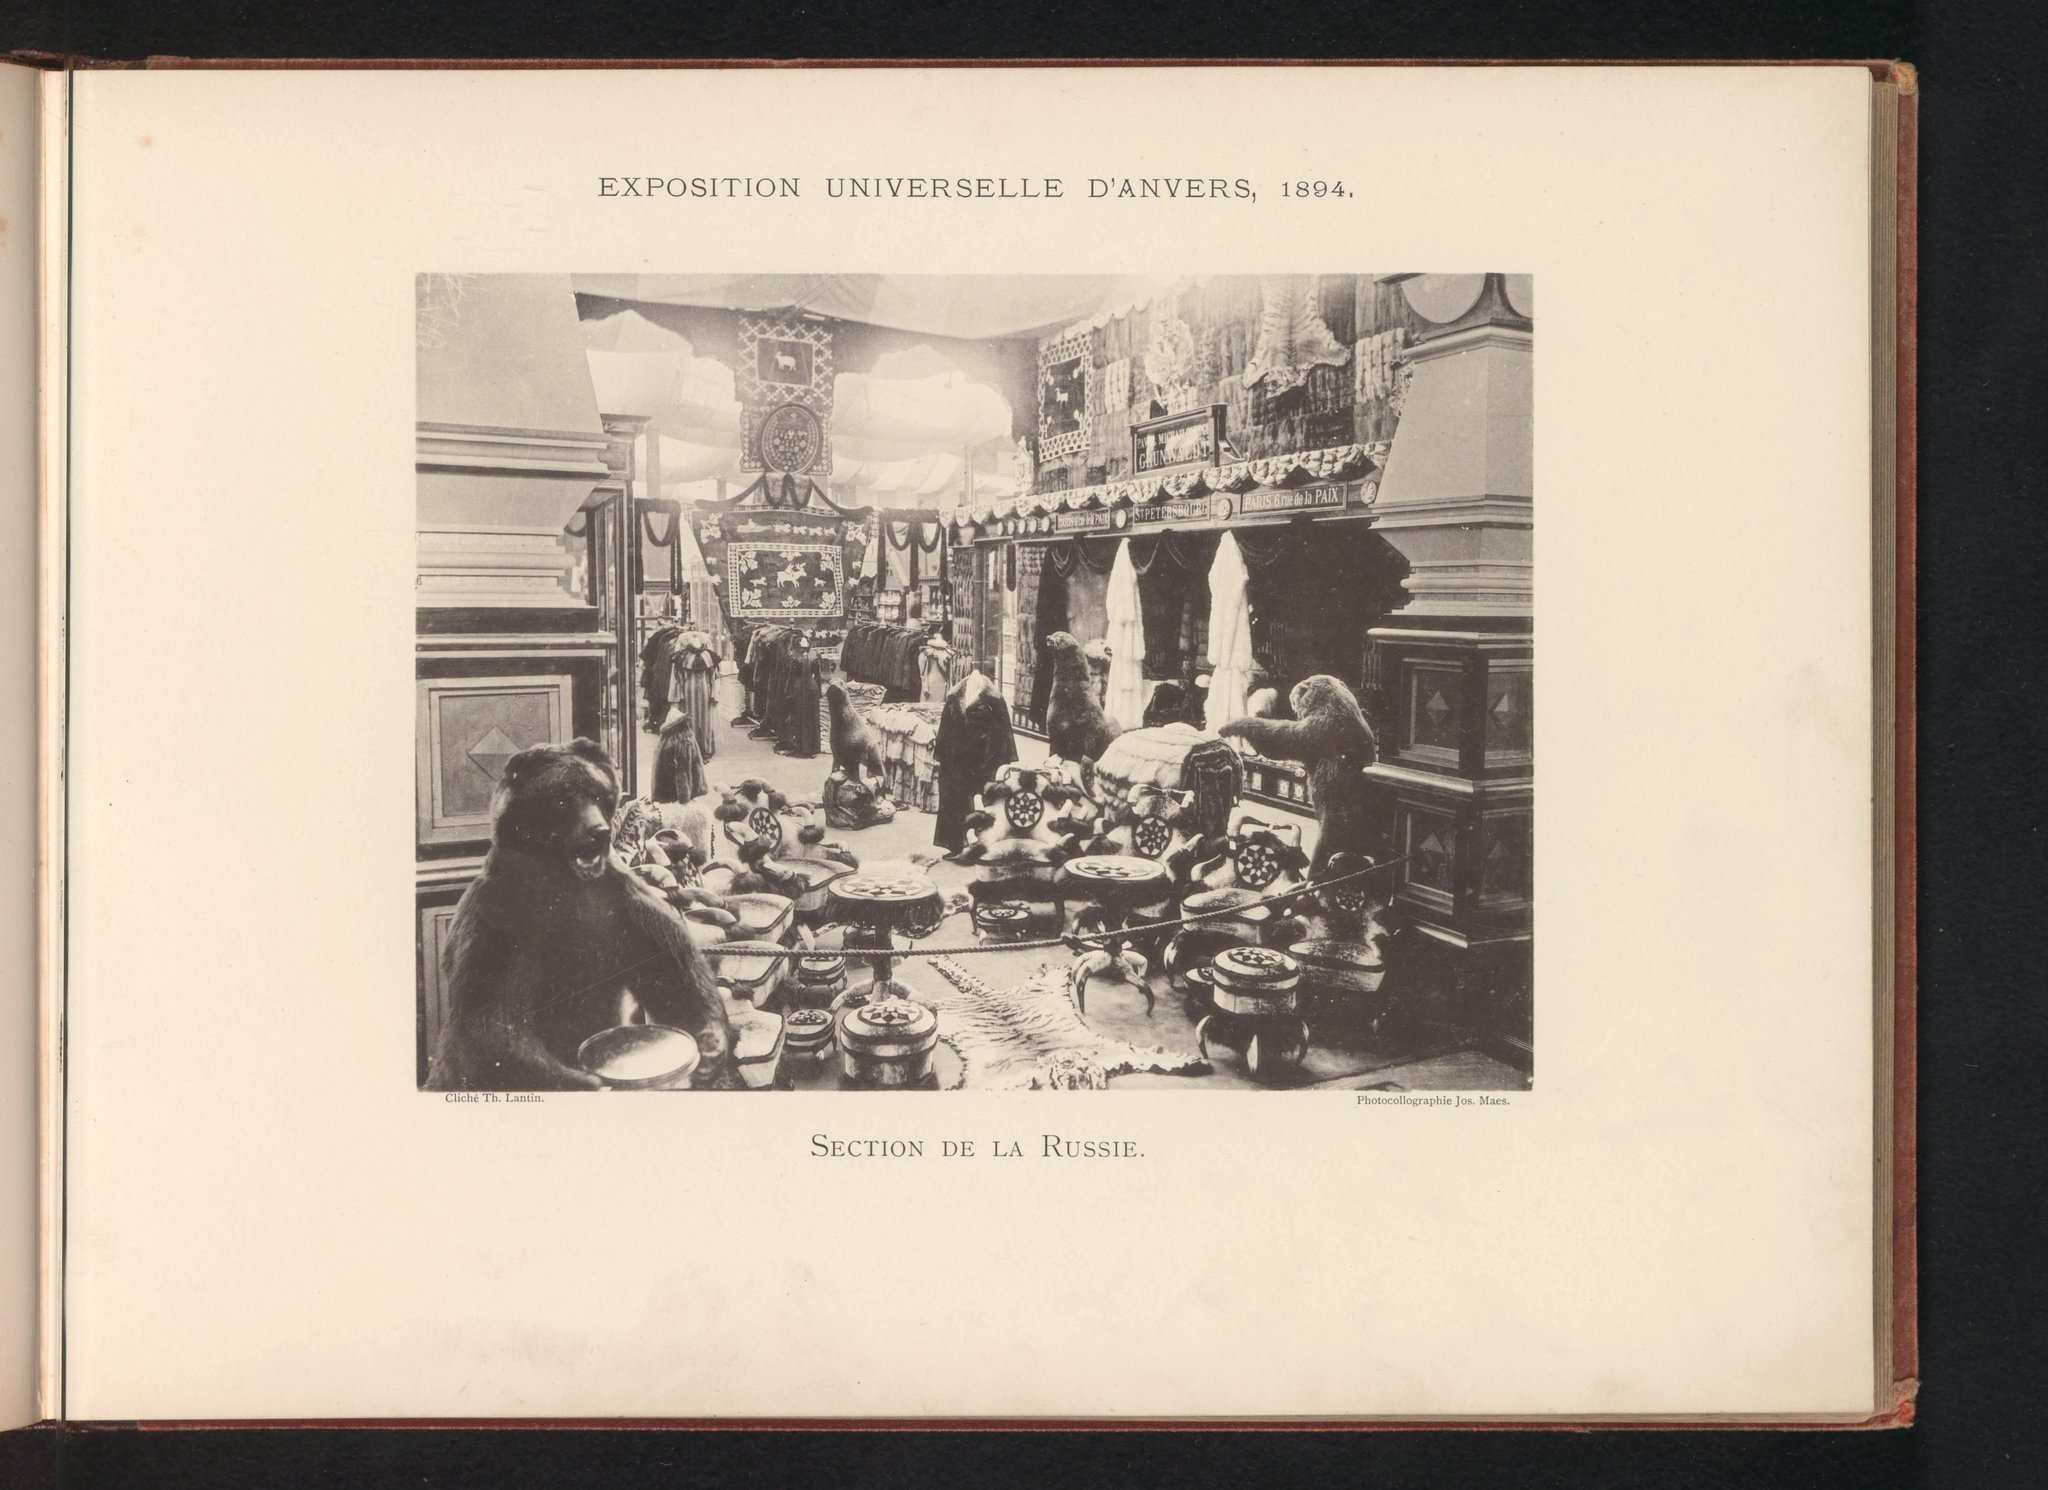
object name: photomechanical print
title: Expositie van Russische bontproducten tijdens de wereldtentoonstelling te Antwerpen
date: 1894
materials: paper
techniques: photograph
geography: antwerp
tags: world fair, world exhibition, spoils of the hunt, game, venison, collection, exhibition, show